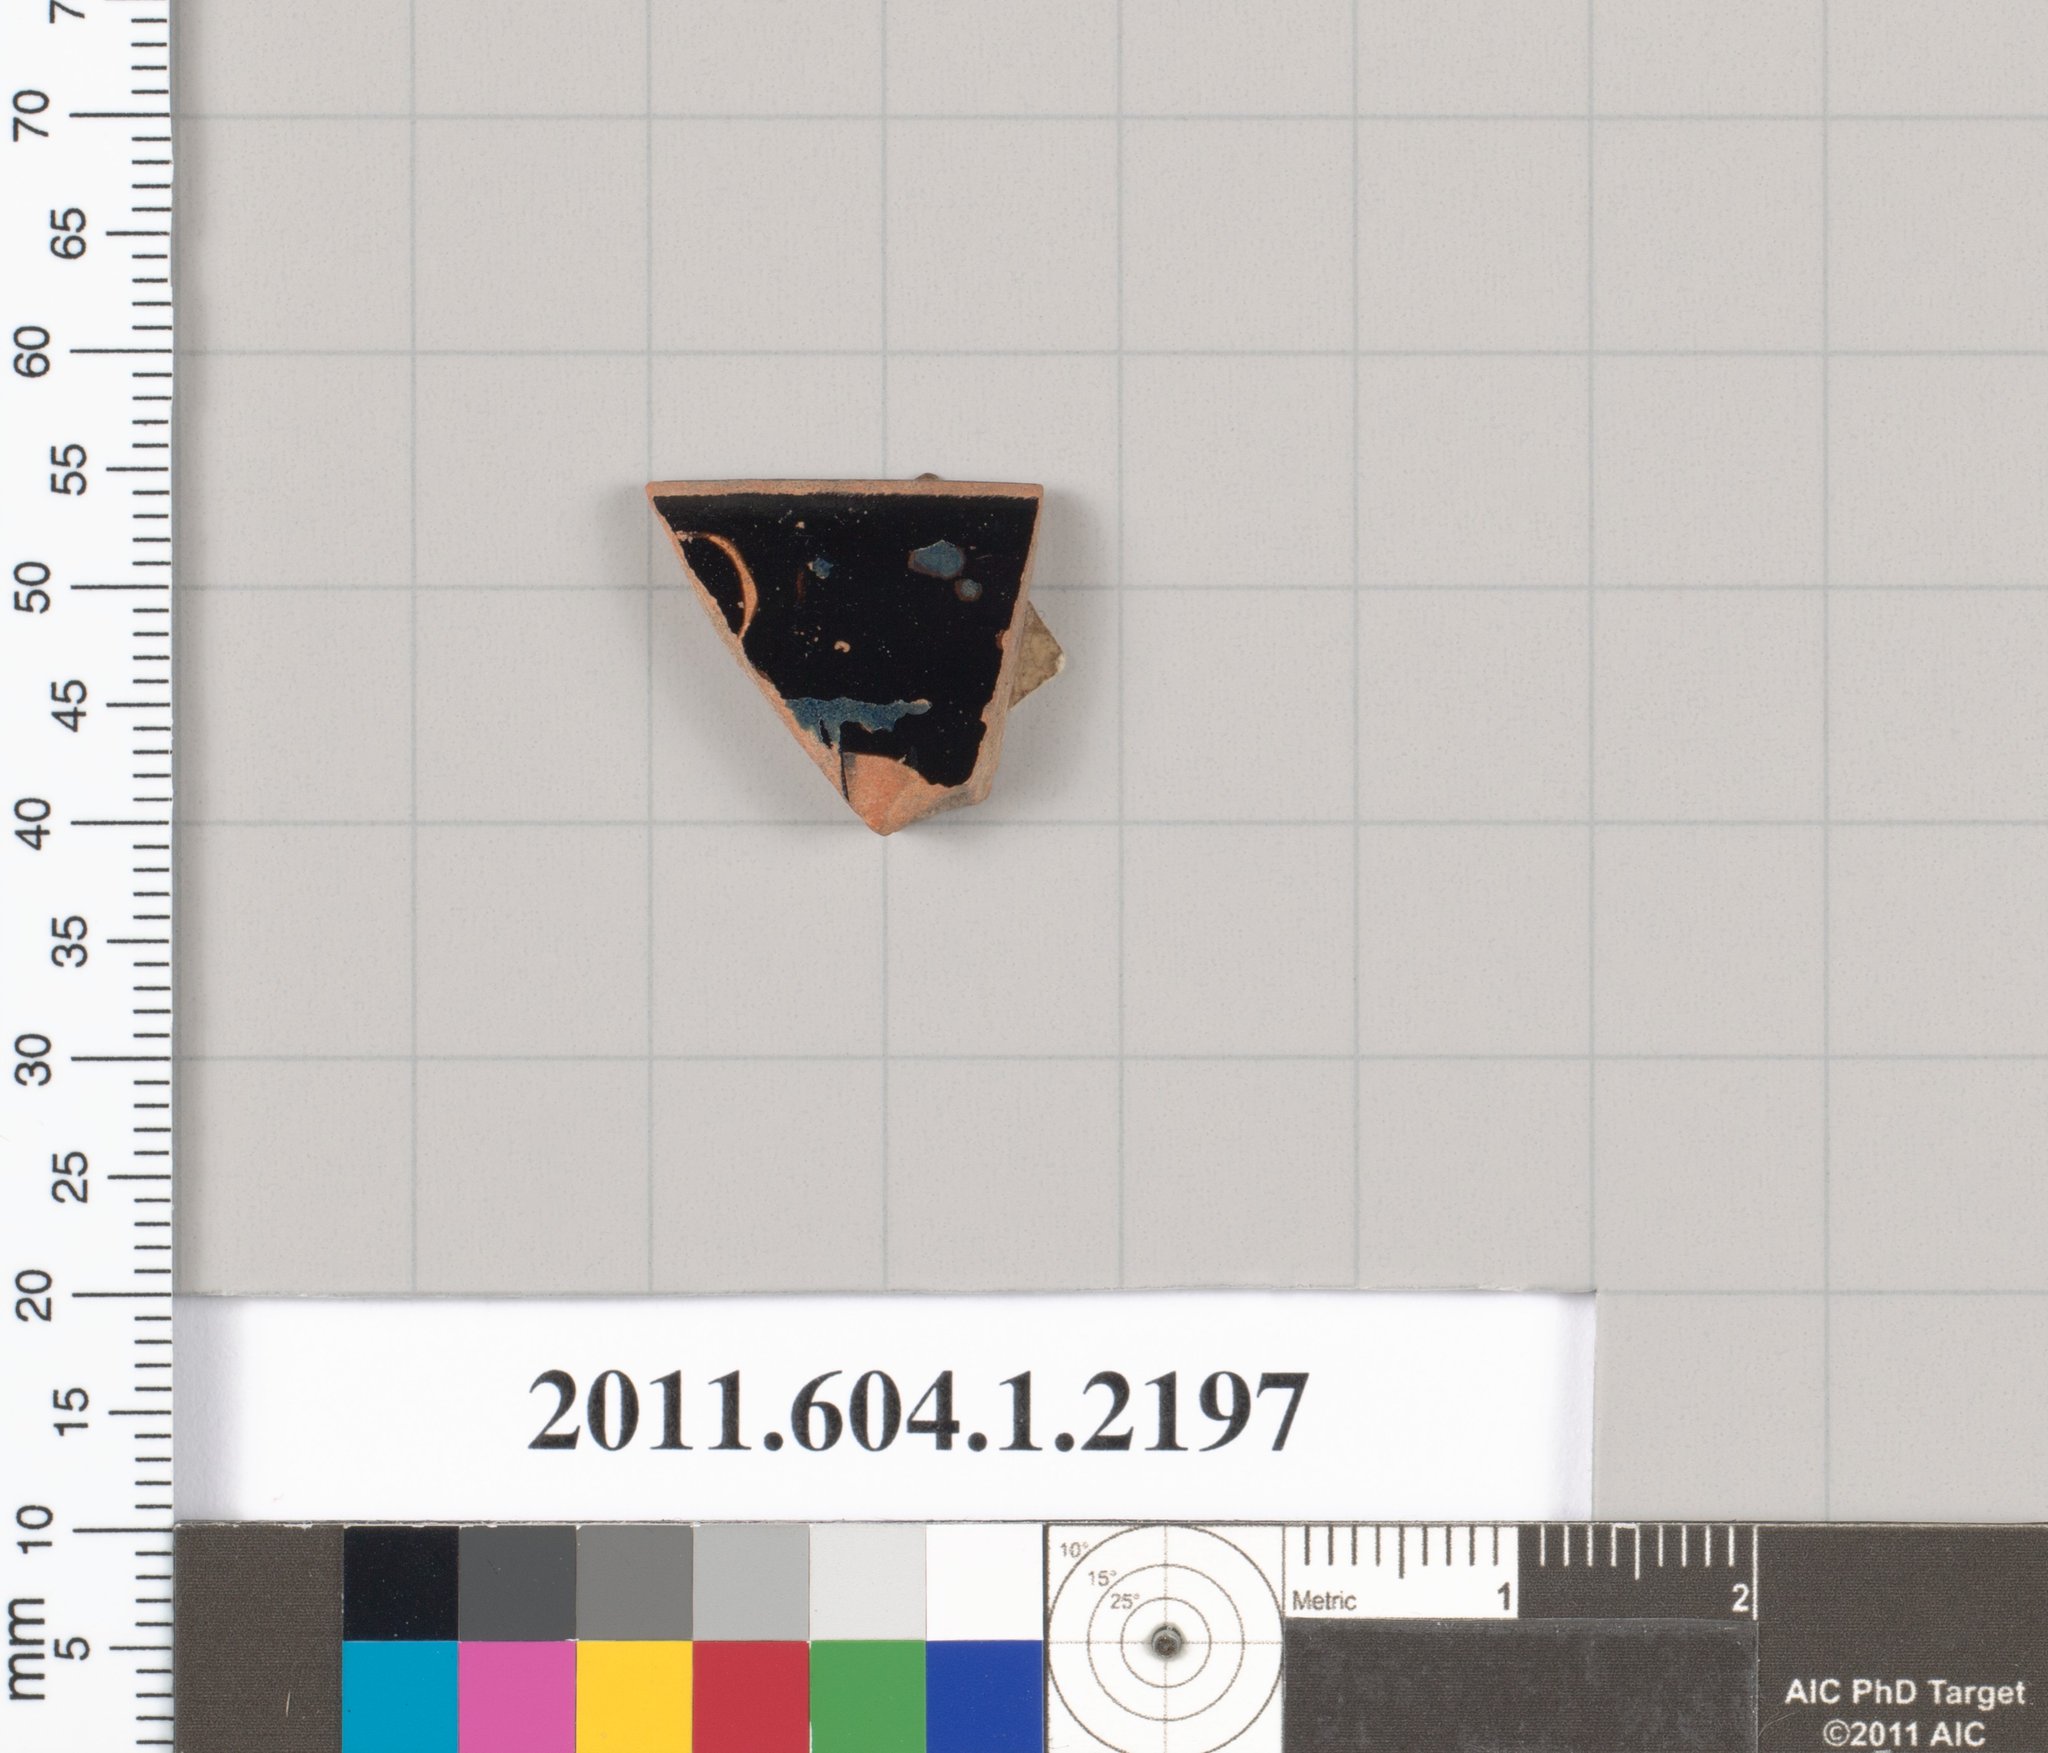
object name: kylix fragment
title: Terracotta rim fragment of a kylix (drinking cup)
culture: greek, attic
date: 500-451 BCE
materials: terracotta